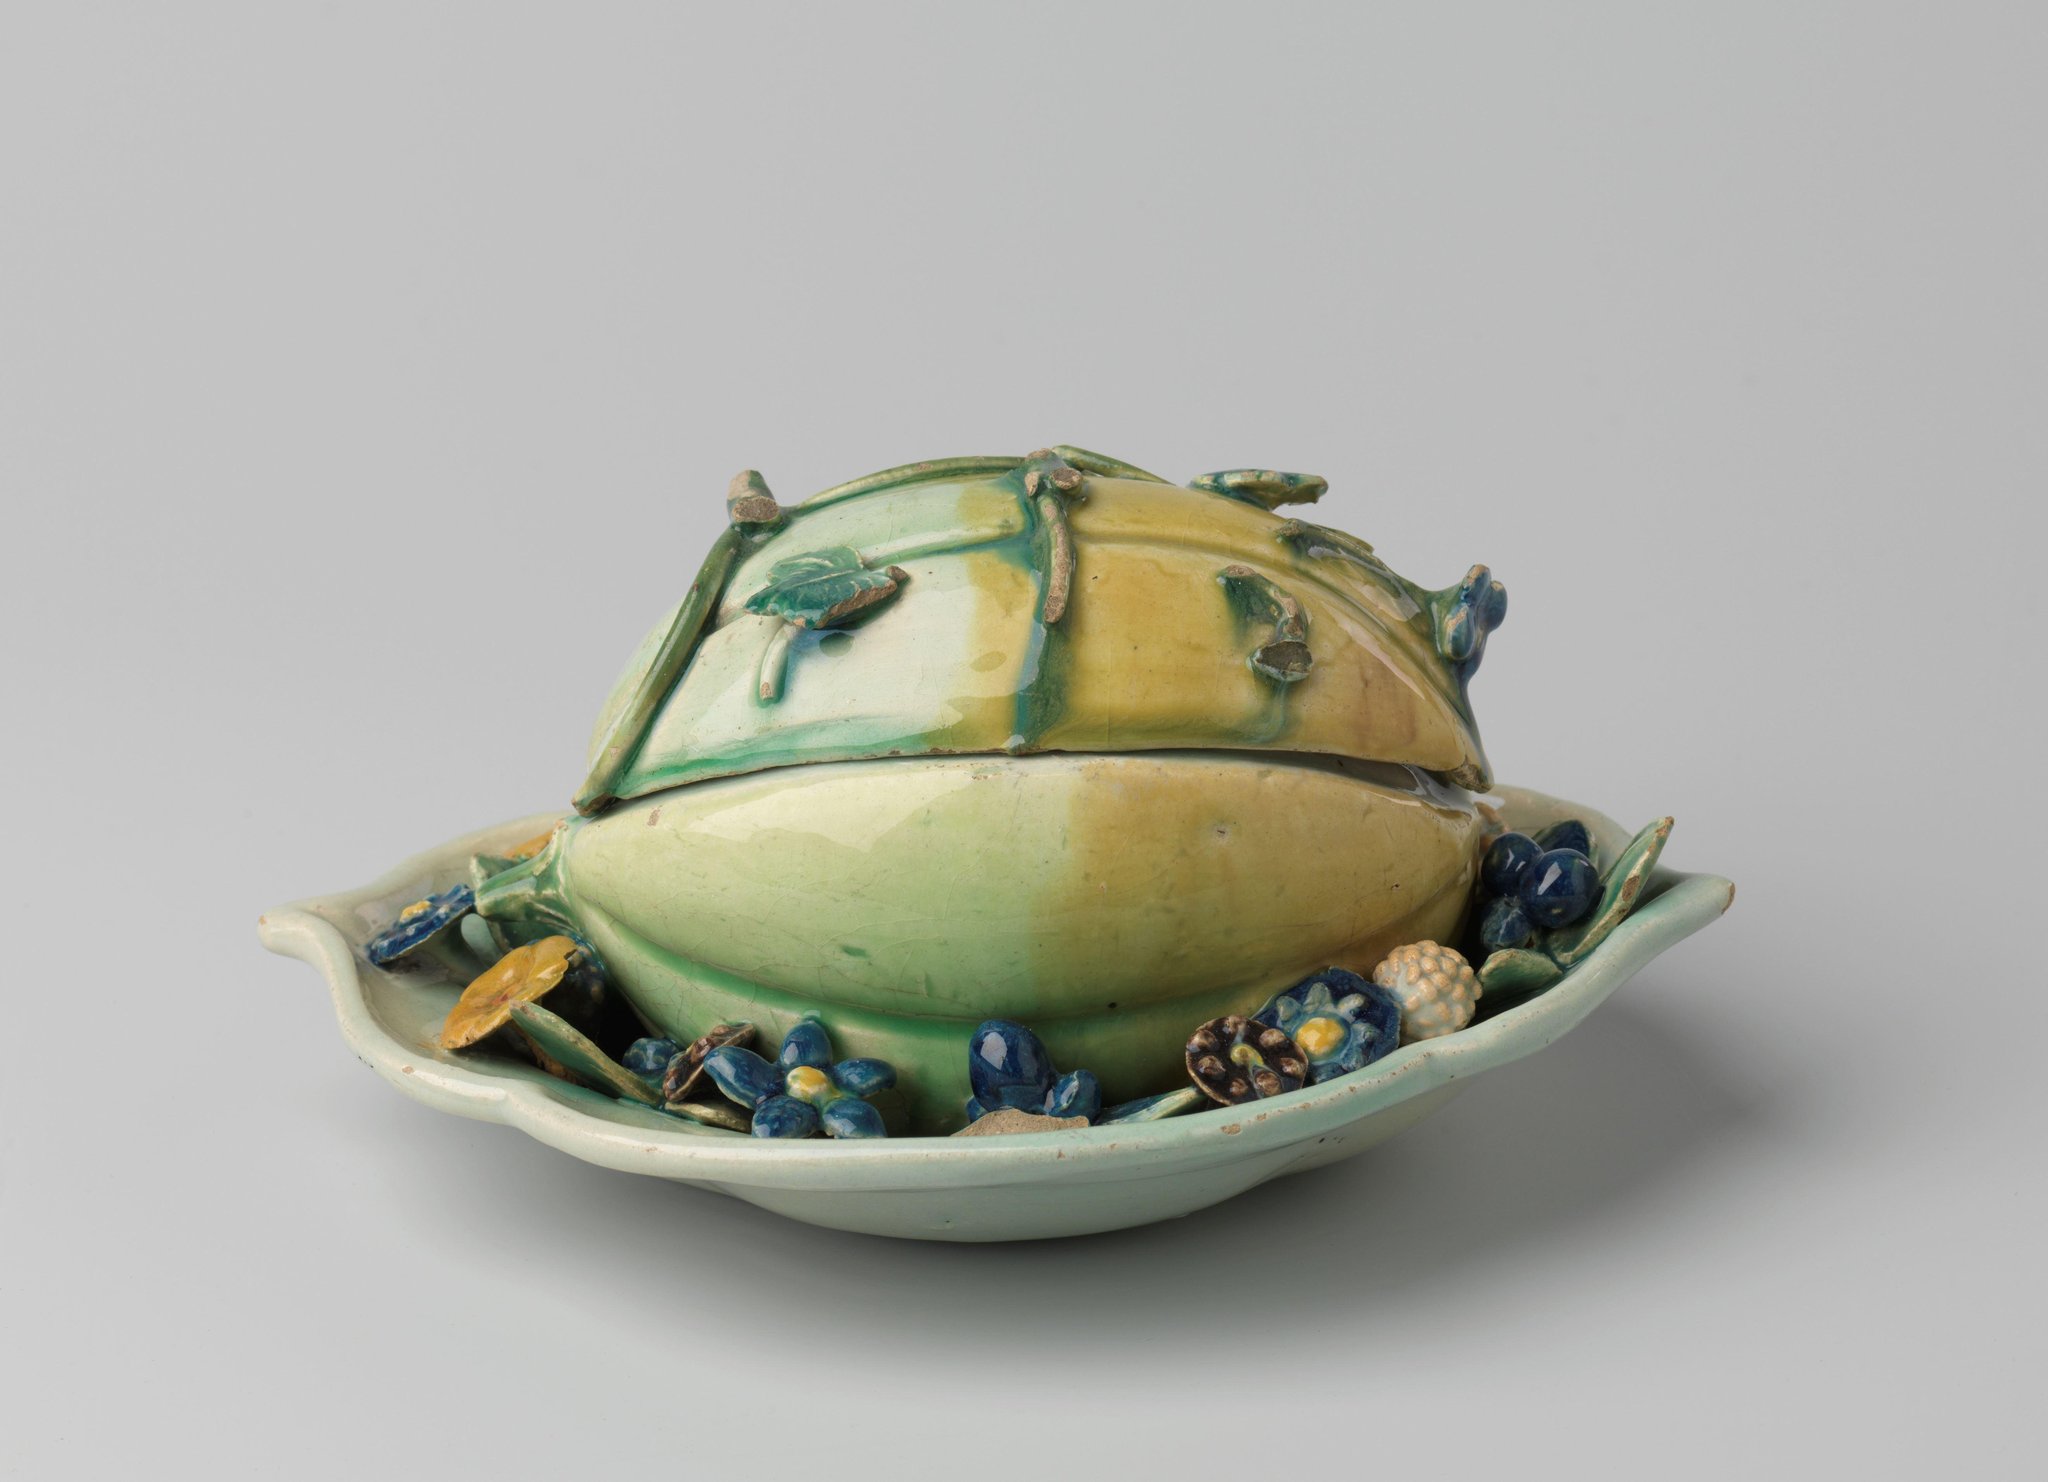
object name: butter dish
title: Botervloot in de vorm van een meloen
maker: arie blankers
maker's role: plateelbakker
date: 1755-1760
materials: earthenware, glaze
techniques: painted, polychromy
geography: amsterdam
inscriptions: mark: ‘AB(ineen)’, mark: ‘A B’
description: Botervloot van veelkleurig beschilderde faience. De botervloot heeft de vorm van een meloen. De botervloot is gemerkt en hoort bij een identieke botervloot met invnr. BK-NM-5018.